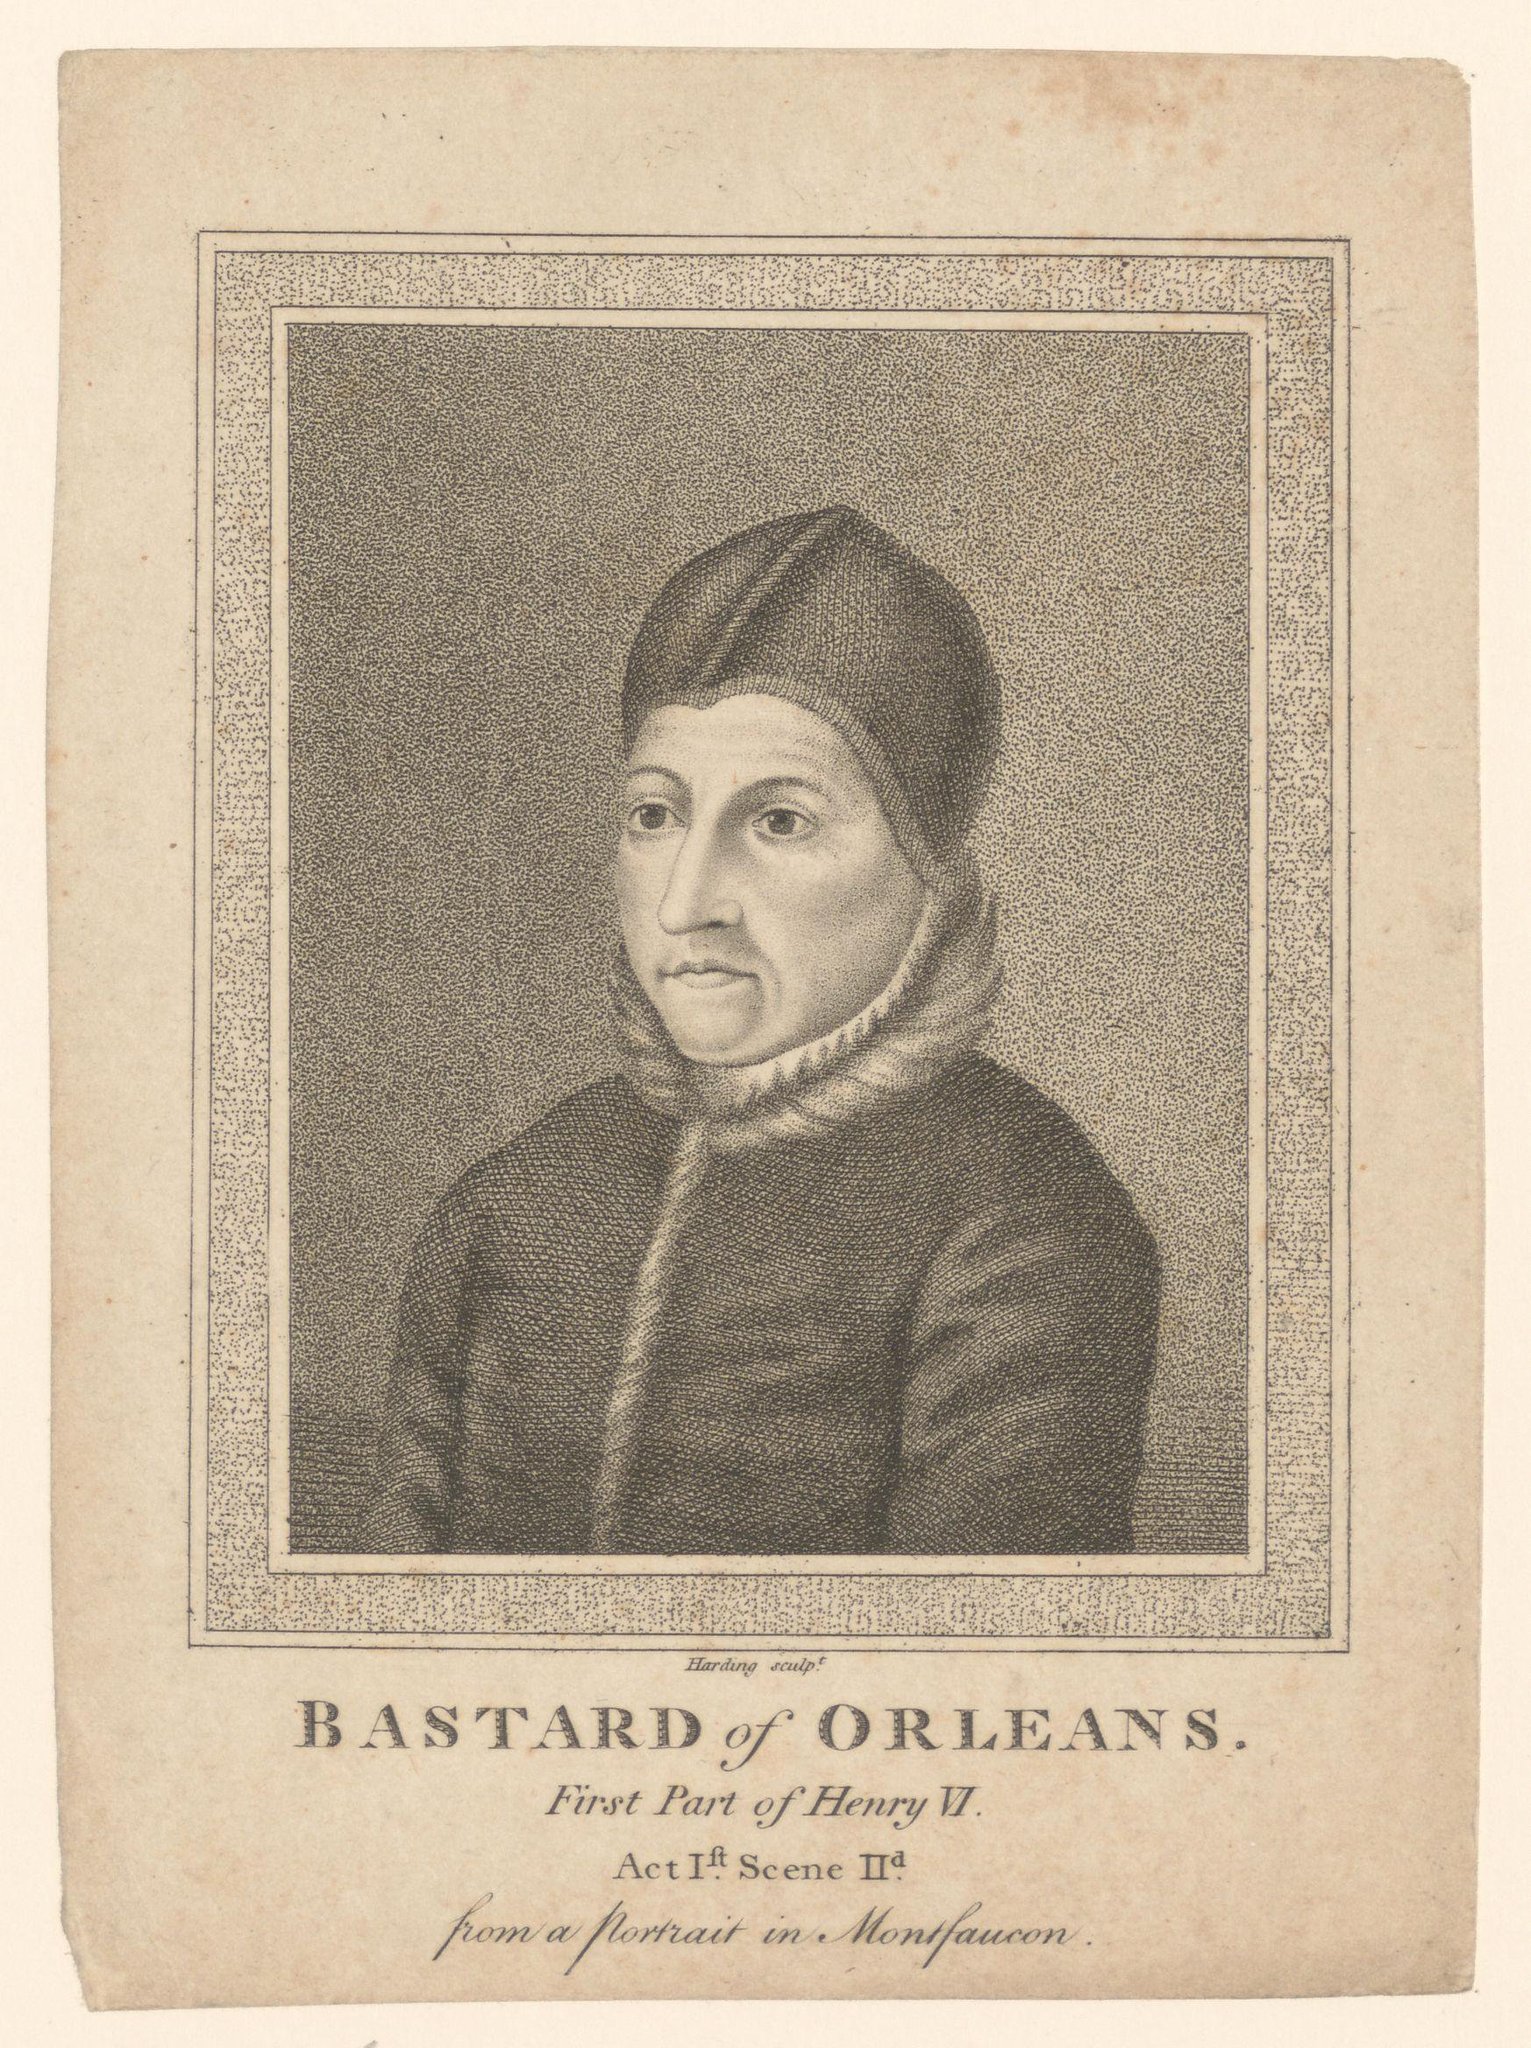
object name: print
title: Shakspeare Illustrated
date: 1793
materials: paper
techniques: etching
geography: london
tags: earl, commander-in-chief, general, marshal, historical persons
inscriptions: collector's mark: Lugt 2228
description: Prent uit: Shak[e]speare Illustrated (...). Londen: Sylvester en Edward Harding, 1793.